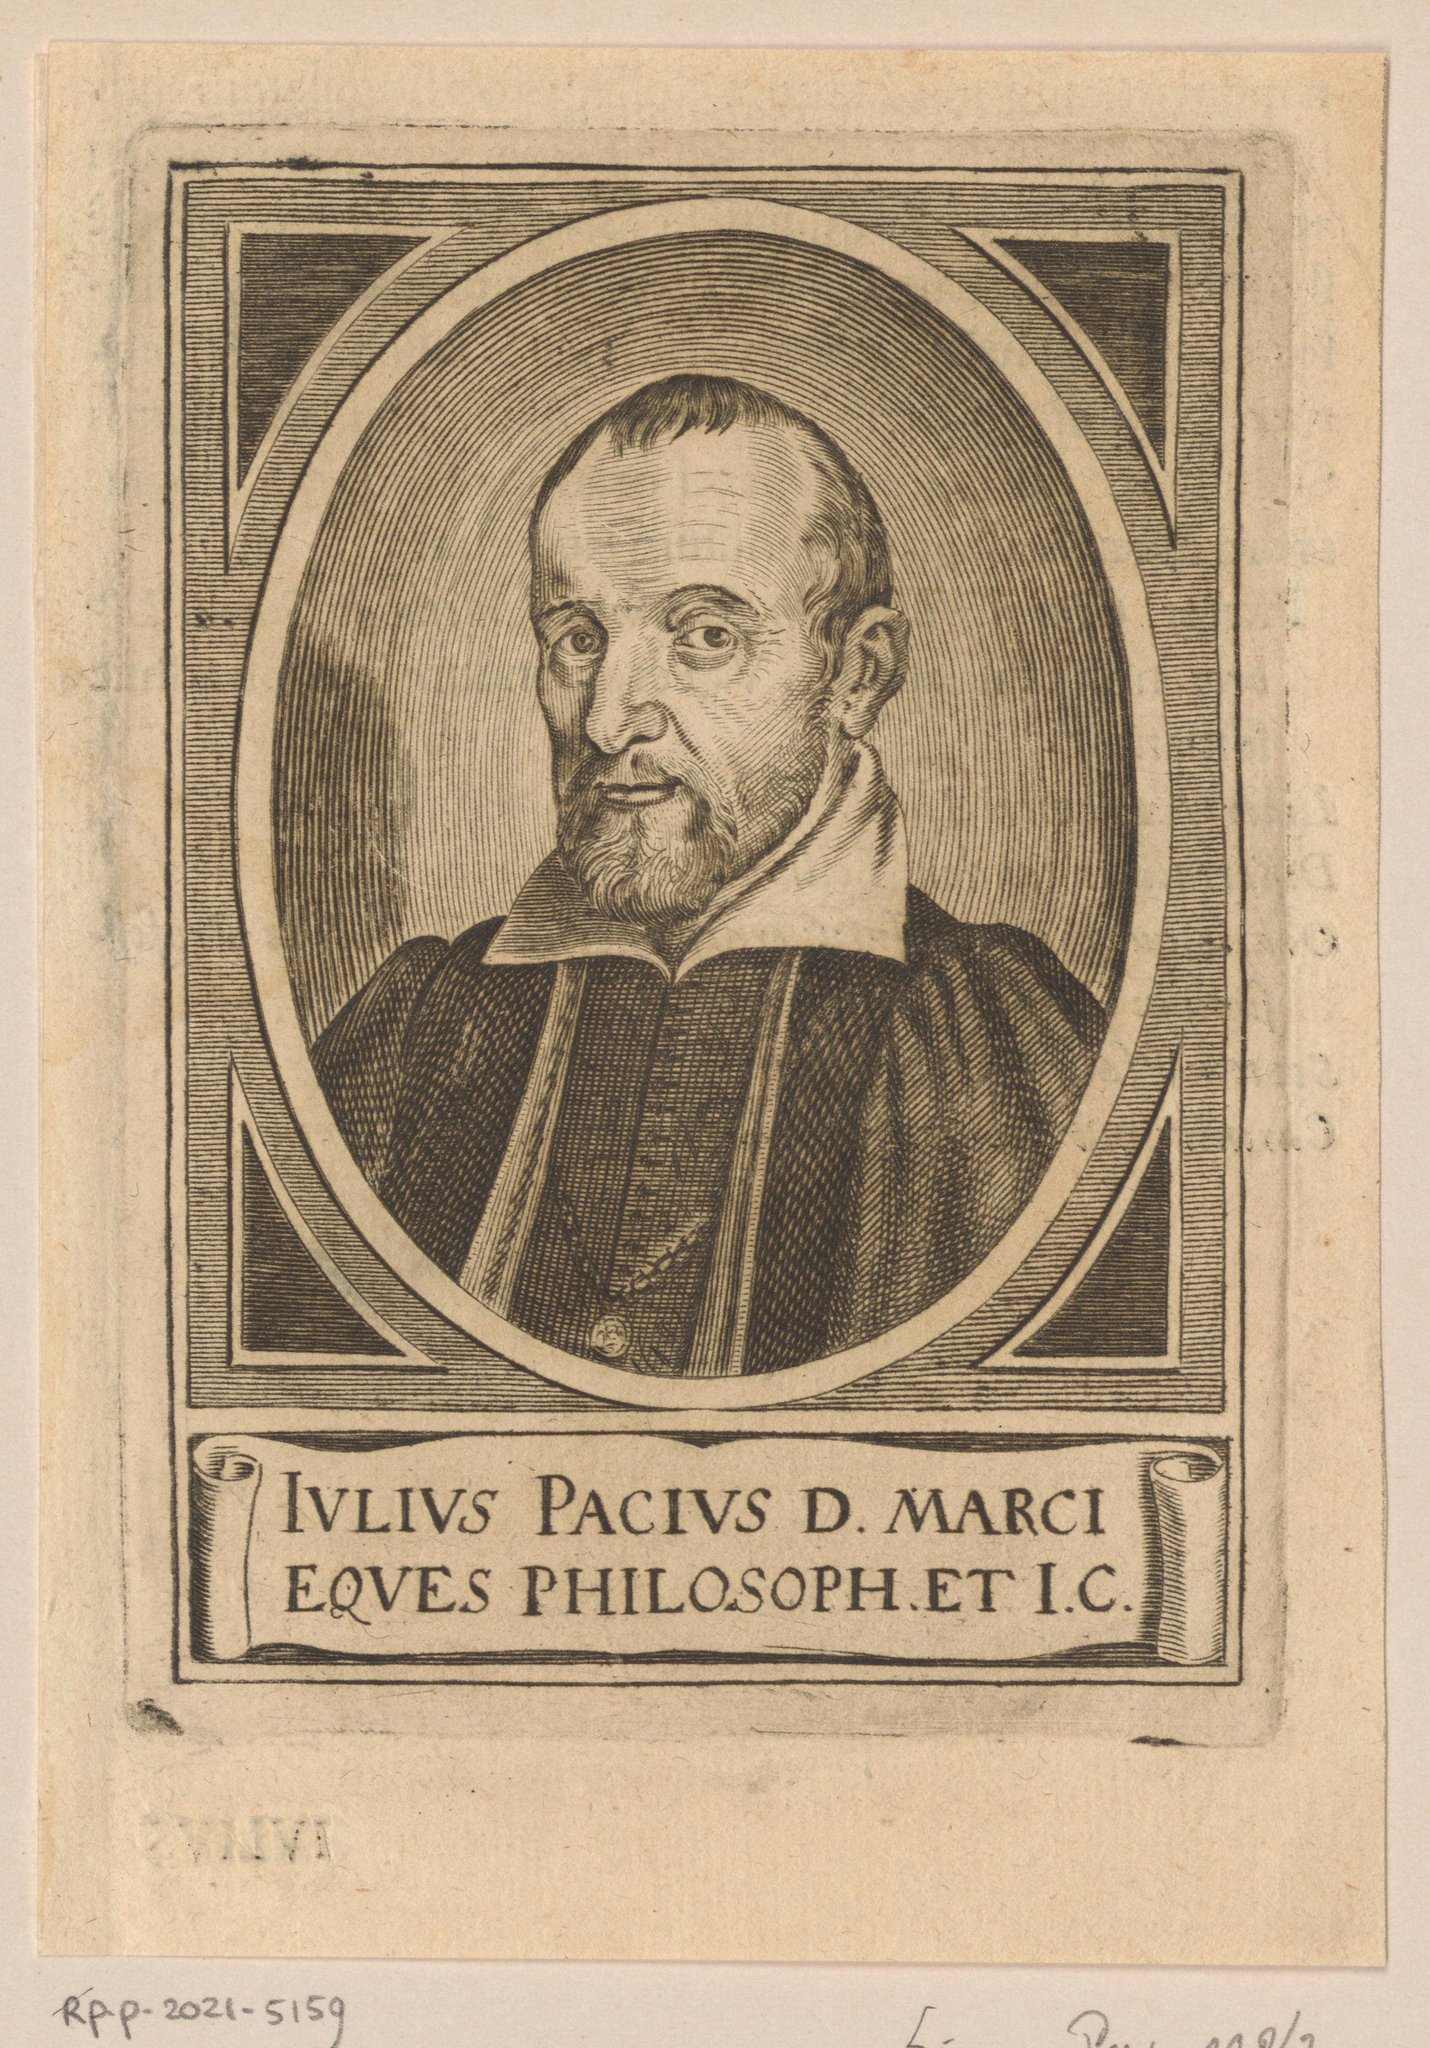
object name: book illustration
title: Portret van Giulio Pace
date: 1644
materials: paper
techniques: engraving, letterpress printing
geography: padua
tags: adult man, historical persons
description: Prent uit: Tomasini, Giacomo Filippo. Elogia virorum literis & sapientia illustrium ad viuum expressis imaginibus exornata (...). Padua: Sebastiano Sardi, 1644.